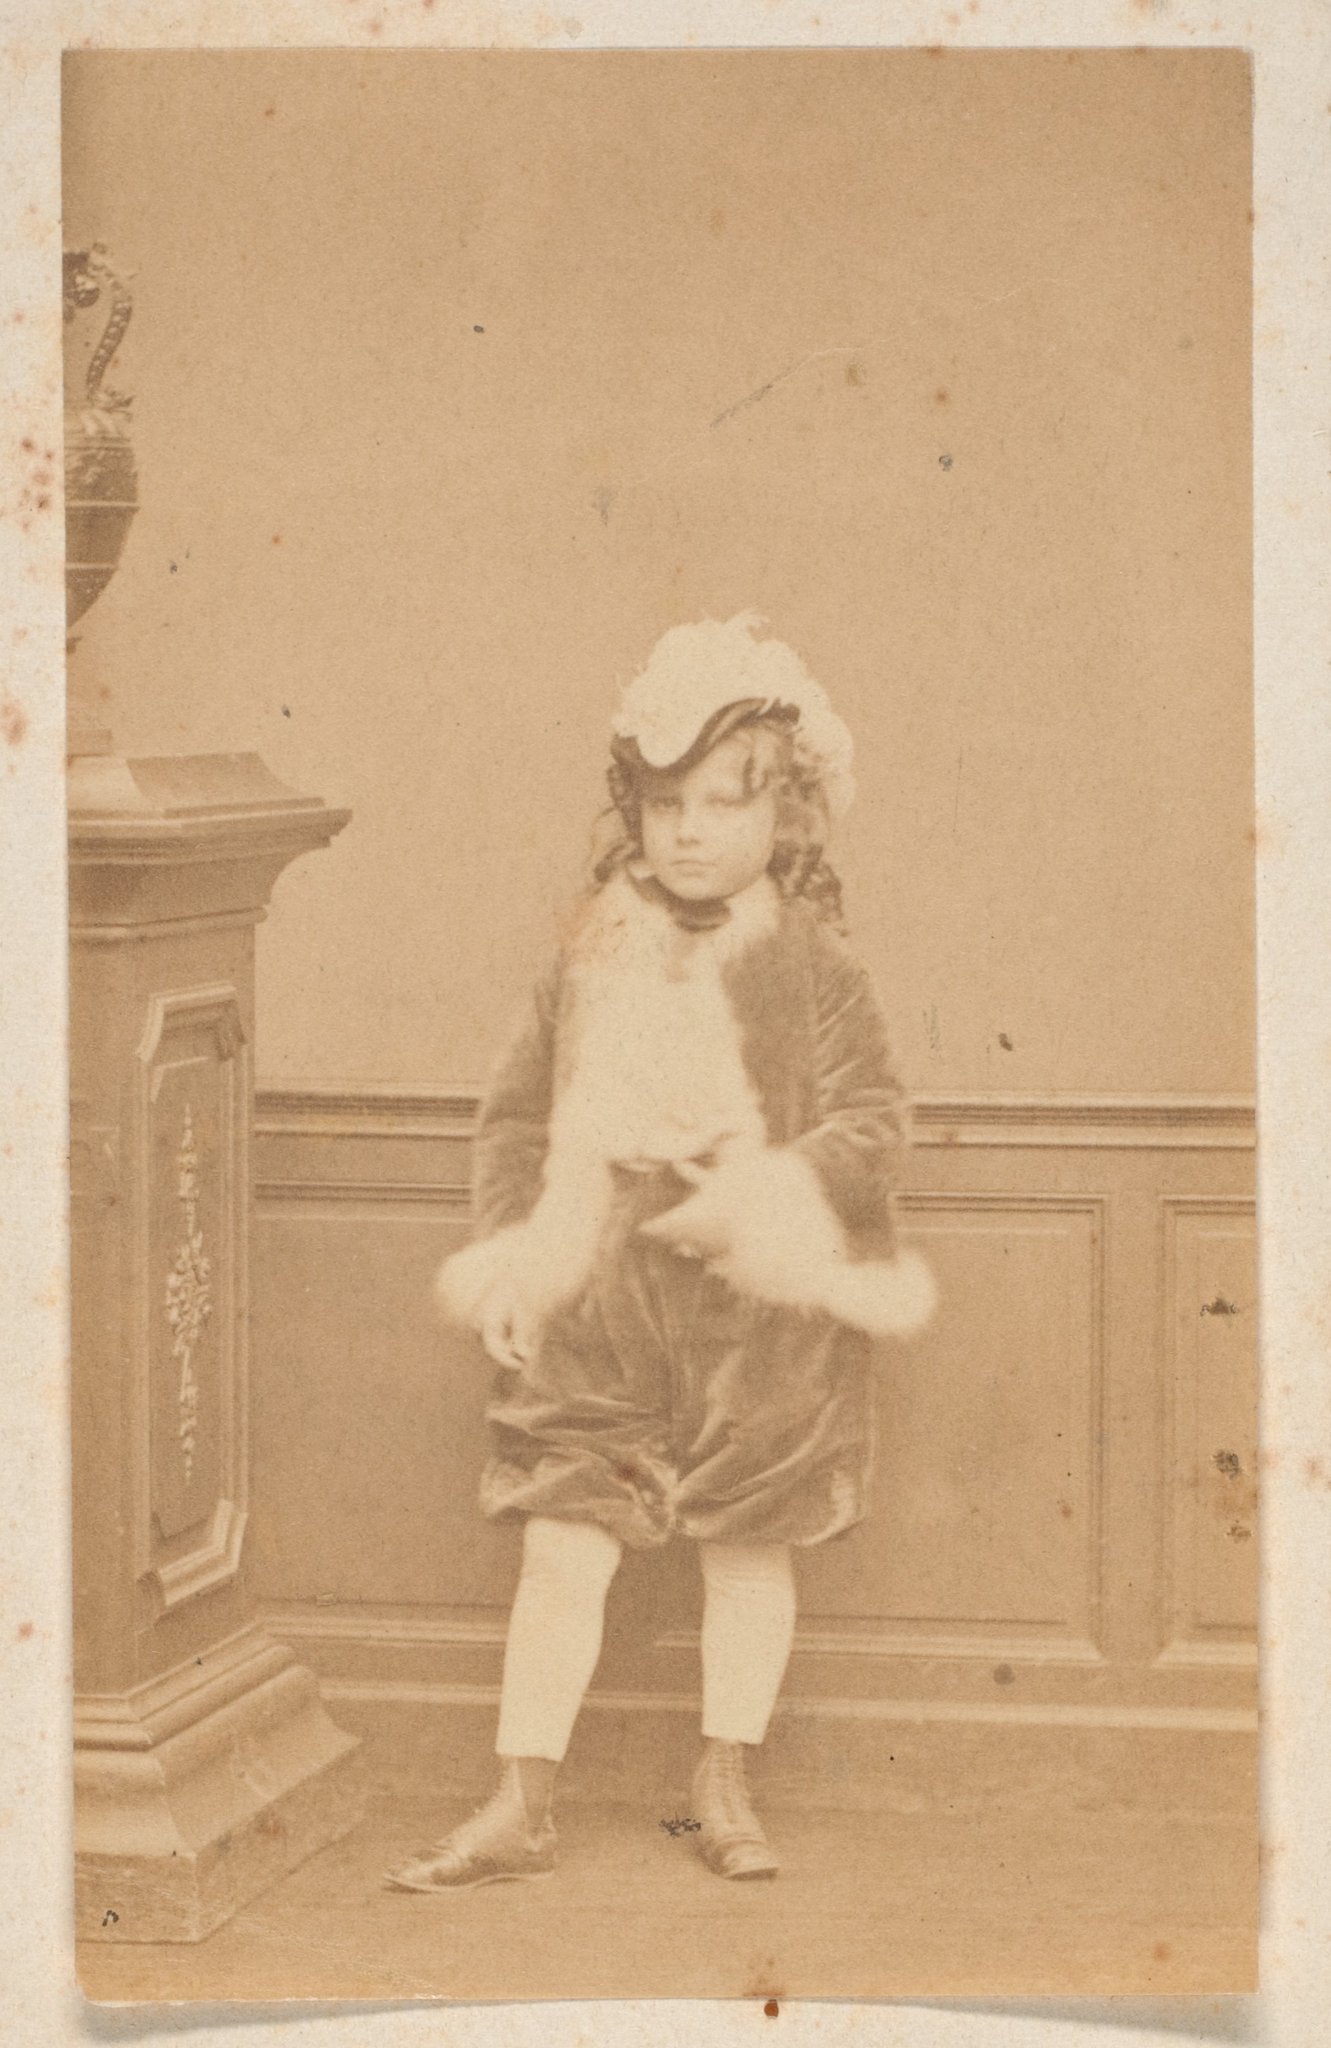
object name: photograph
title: La veste de Cygne (autre)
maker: pierre-louis pierson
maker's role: artist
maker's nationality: french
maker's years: 1822-1913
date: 1860-1869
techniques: albumen silver print, glass negative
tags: children,portraits